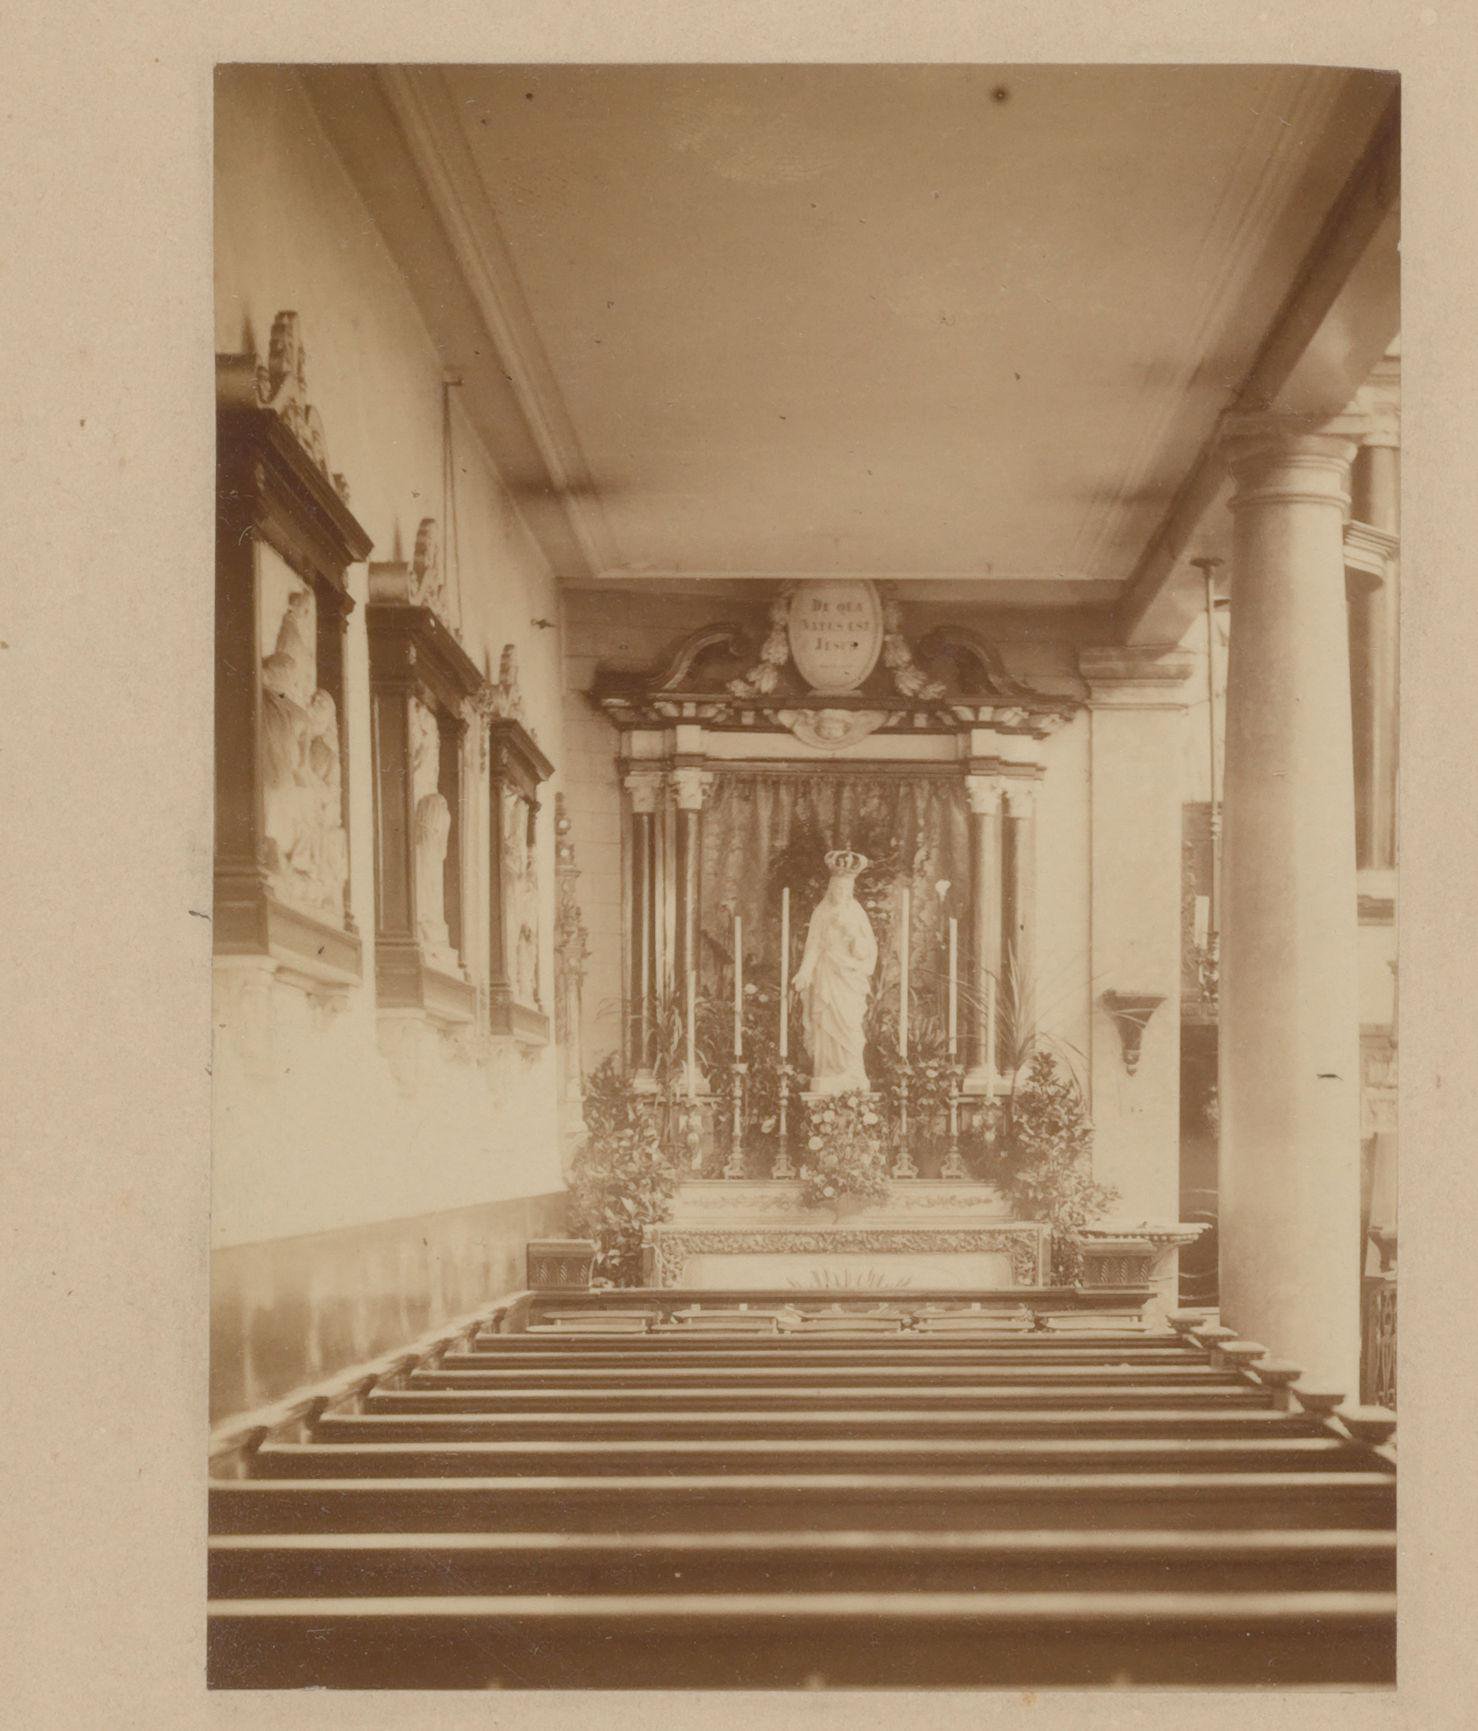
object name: photograph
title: Altaar in de linkerzijbeuk van de Krijtberg te Amsterdam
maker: Anonymous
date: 1860-1881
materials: paper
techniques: albumen print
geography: amsterdam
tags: interior of church, altar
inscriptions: collector's mark: Lugt 1641b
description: Onderwerpsrubriek binnen de Atlas Amsterdam: Kerkwezen: R.K. Gemeenten: Begijnhof t/m Petrus en Paulus.